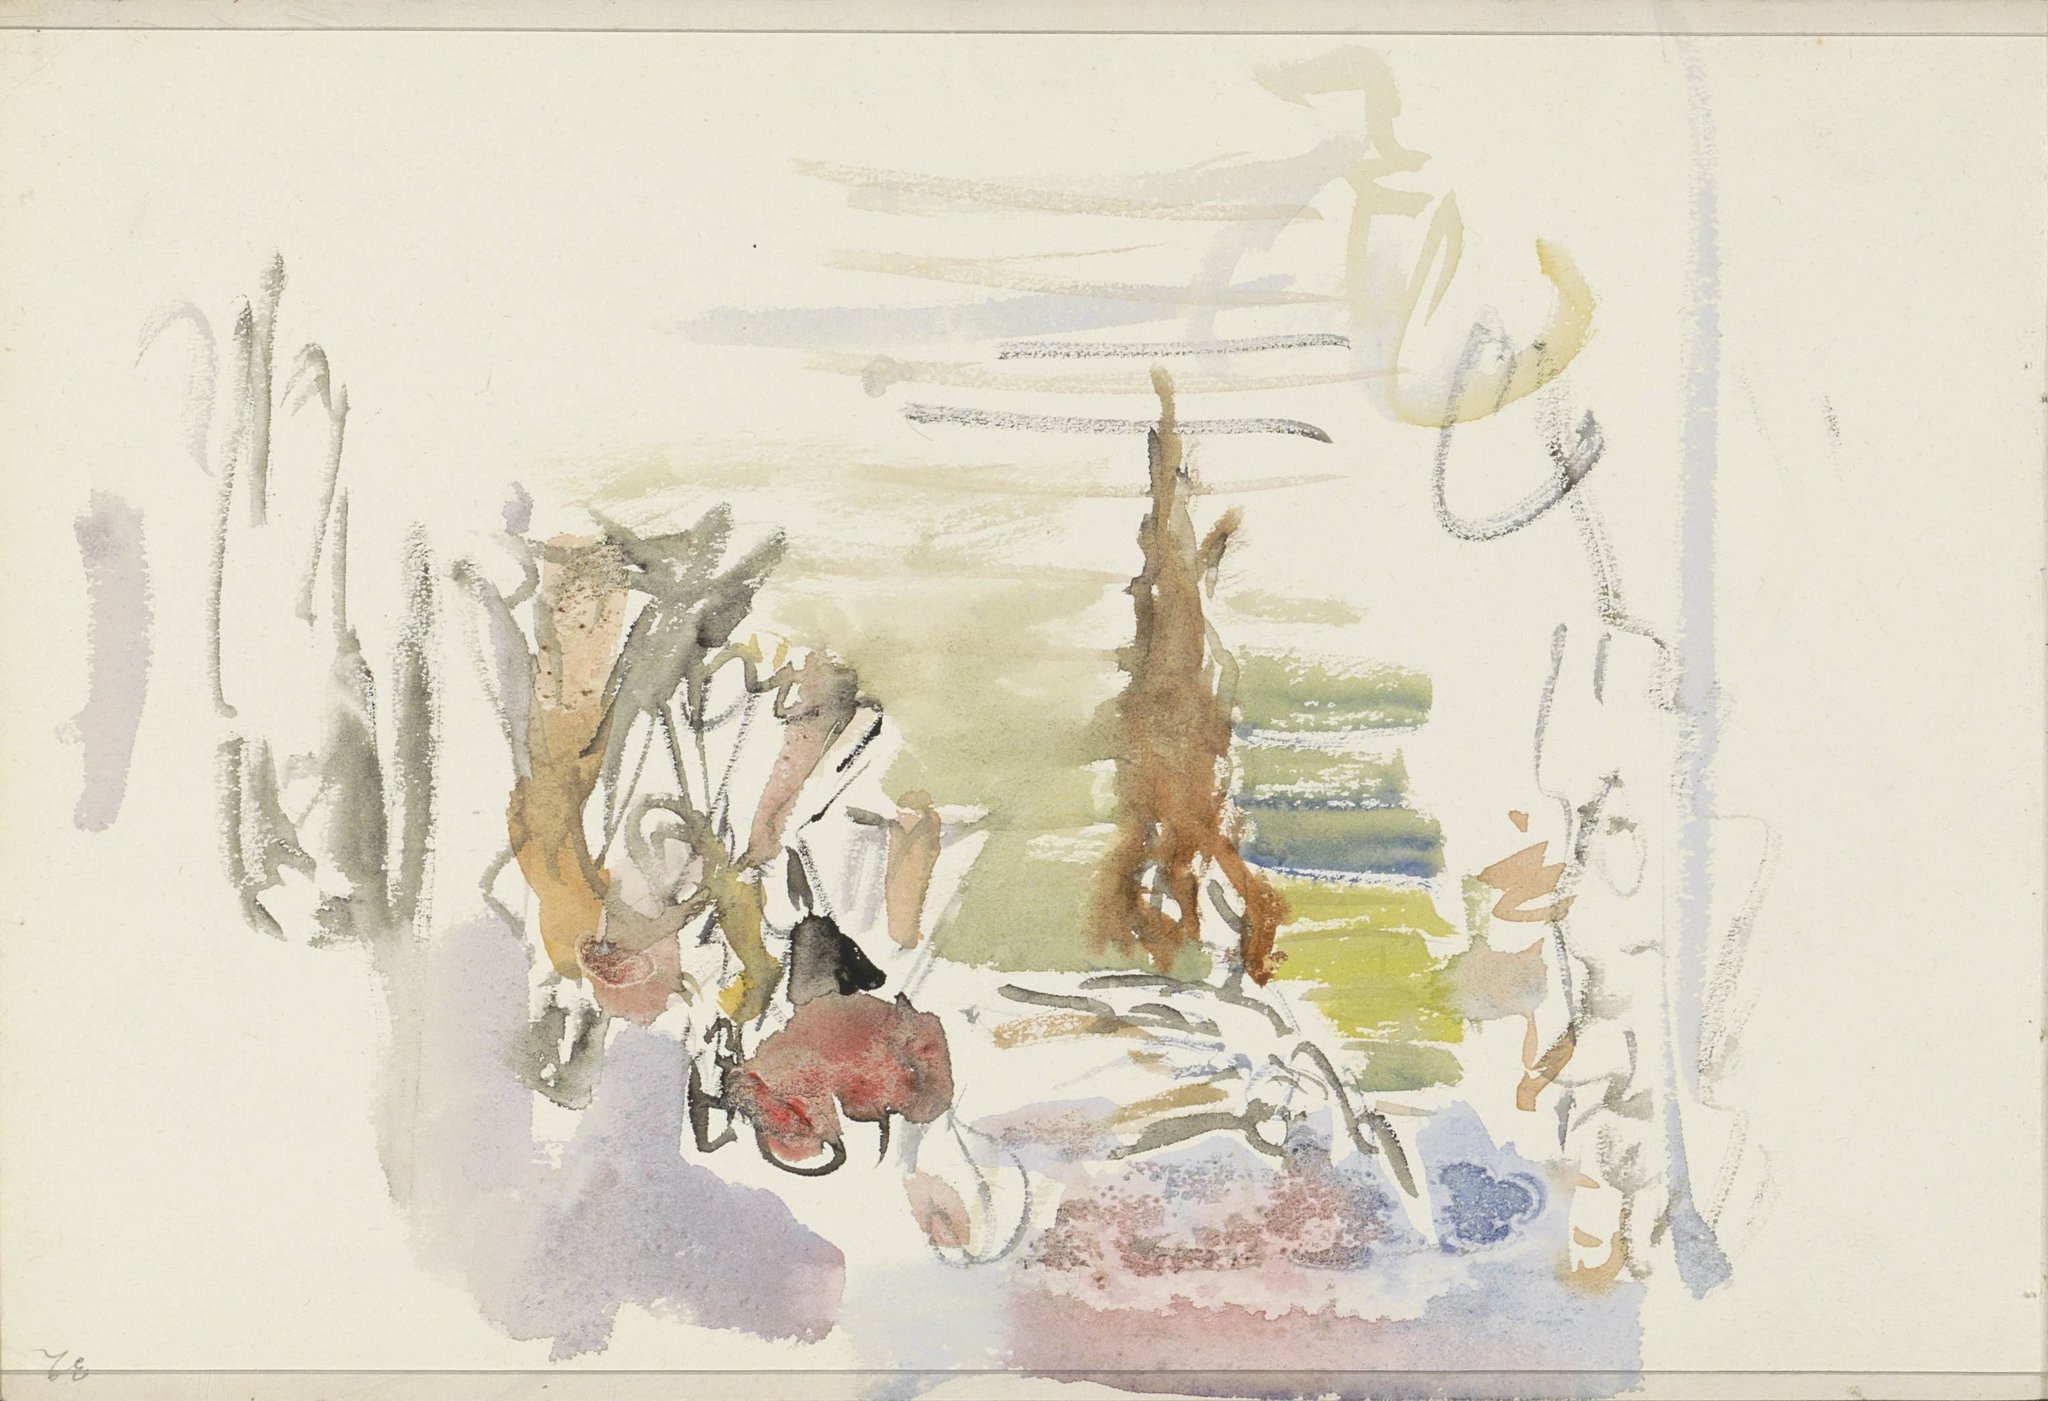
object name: sketchbook leaf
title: Artiesten op het toneel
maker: isaac israels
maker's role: draughtsman, painter, print maker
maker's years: 1865-1934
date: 1875-1934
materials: paper, watercolor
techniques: brush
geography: the hague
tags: theatre, theatrical performance, the stage and its equipment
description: Mogelijk acrobaten of dansers. Blad 3 verso uit schetsboek XXVIII met 17 bladen.